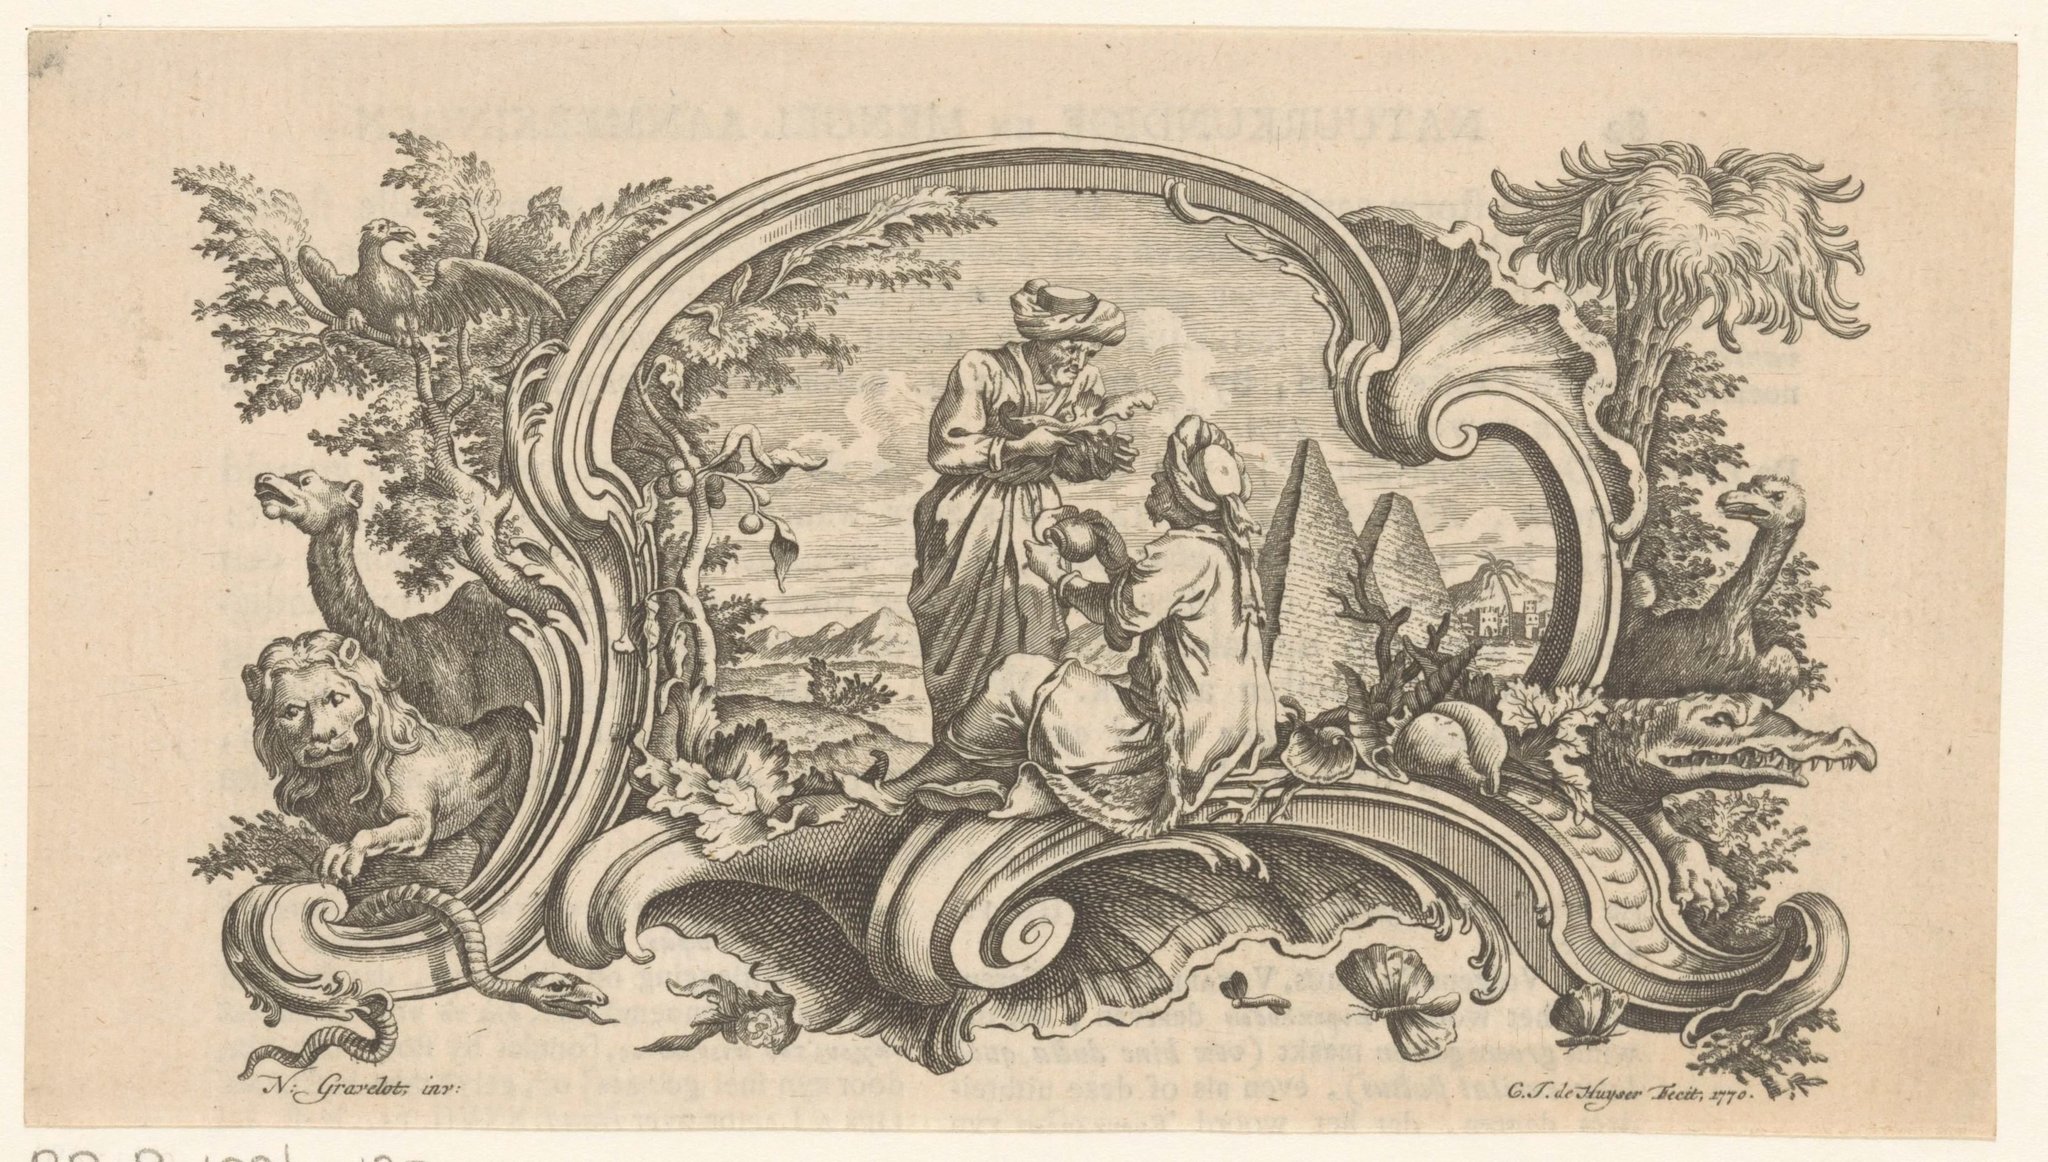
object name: book illustration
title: Vignet met allegorie op het Midden-Oosten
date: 1770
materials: paper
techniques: engraving, etching, letterpress printing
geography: utrecht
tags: continents represented allegorically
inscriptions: collector's mark: Lugt 2760, collector's mark: Lugt 2228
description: Vignet met twee mannen met schelpen in hun handen. In de achtergrond een landschap met piramiden. Rondom een rocaille omlijsting met bomen en dieren zoals een leeuw, een kameel, en een krokodil.